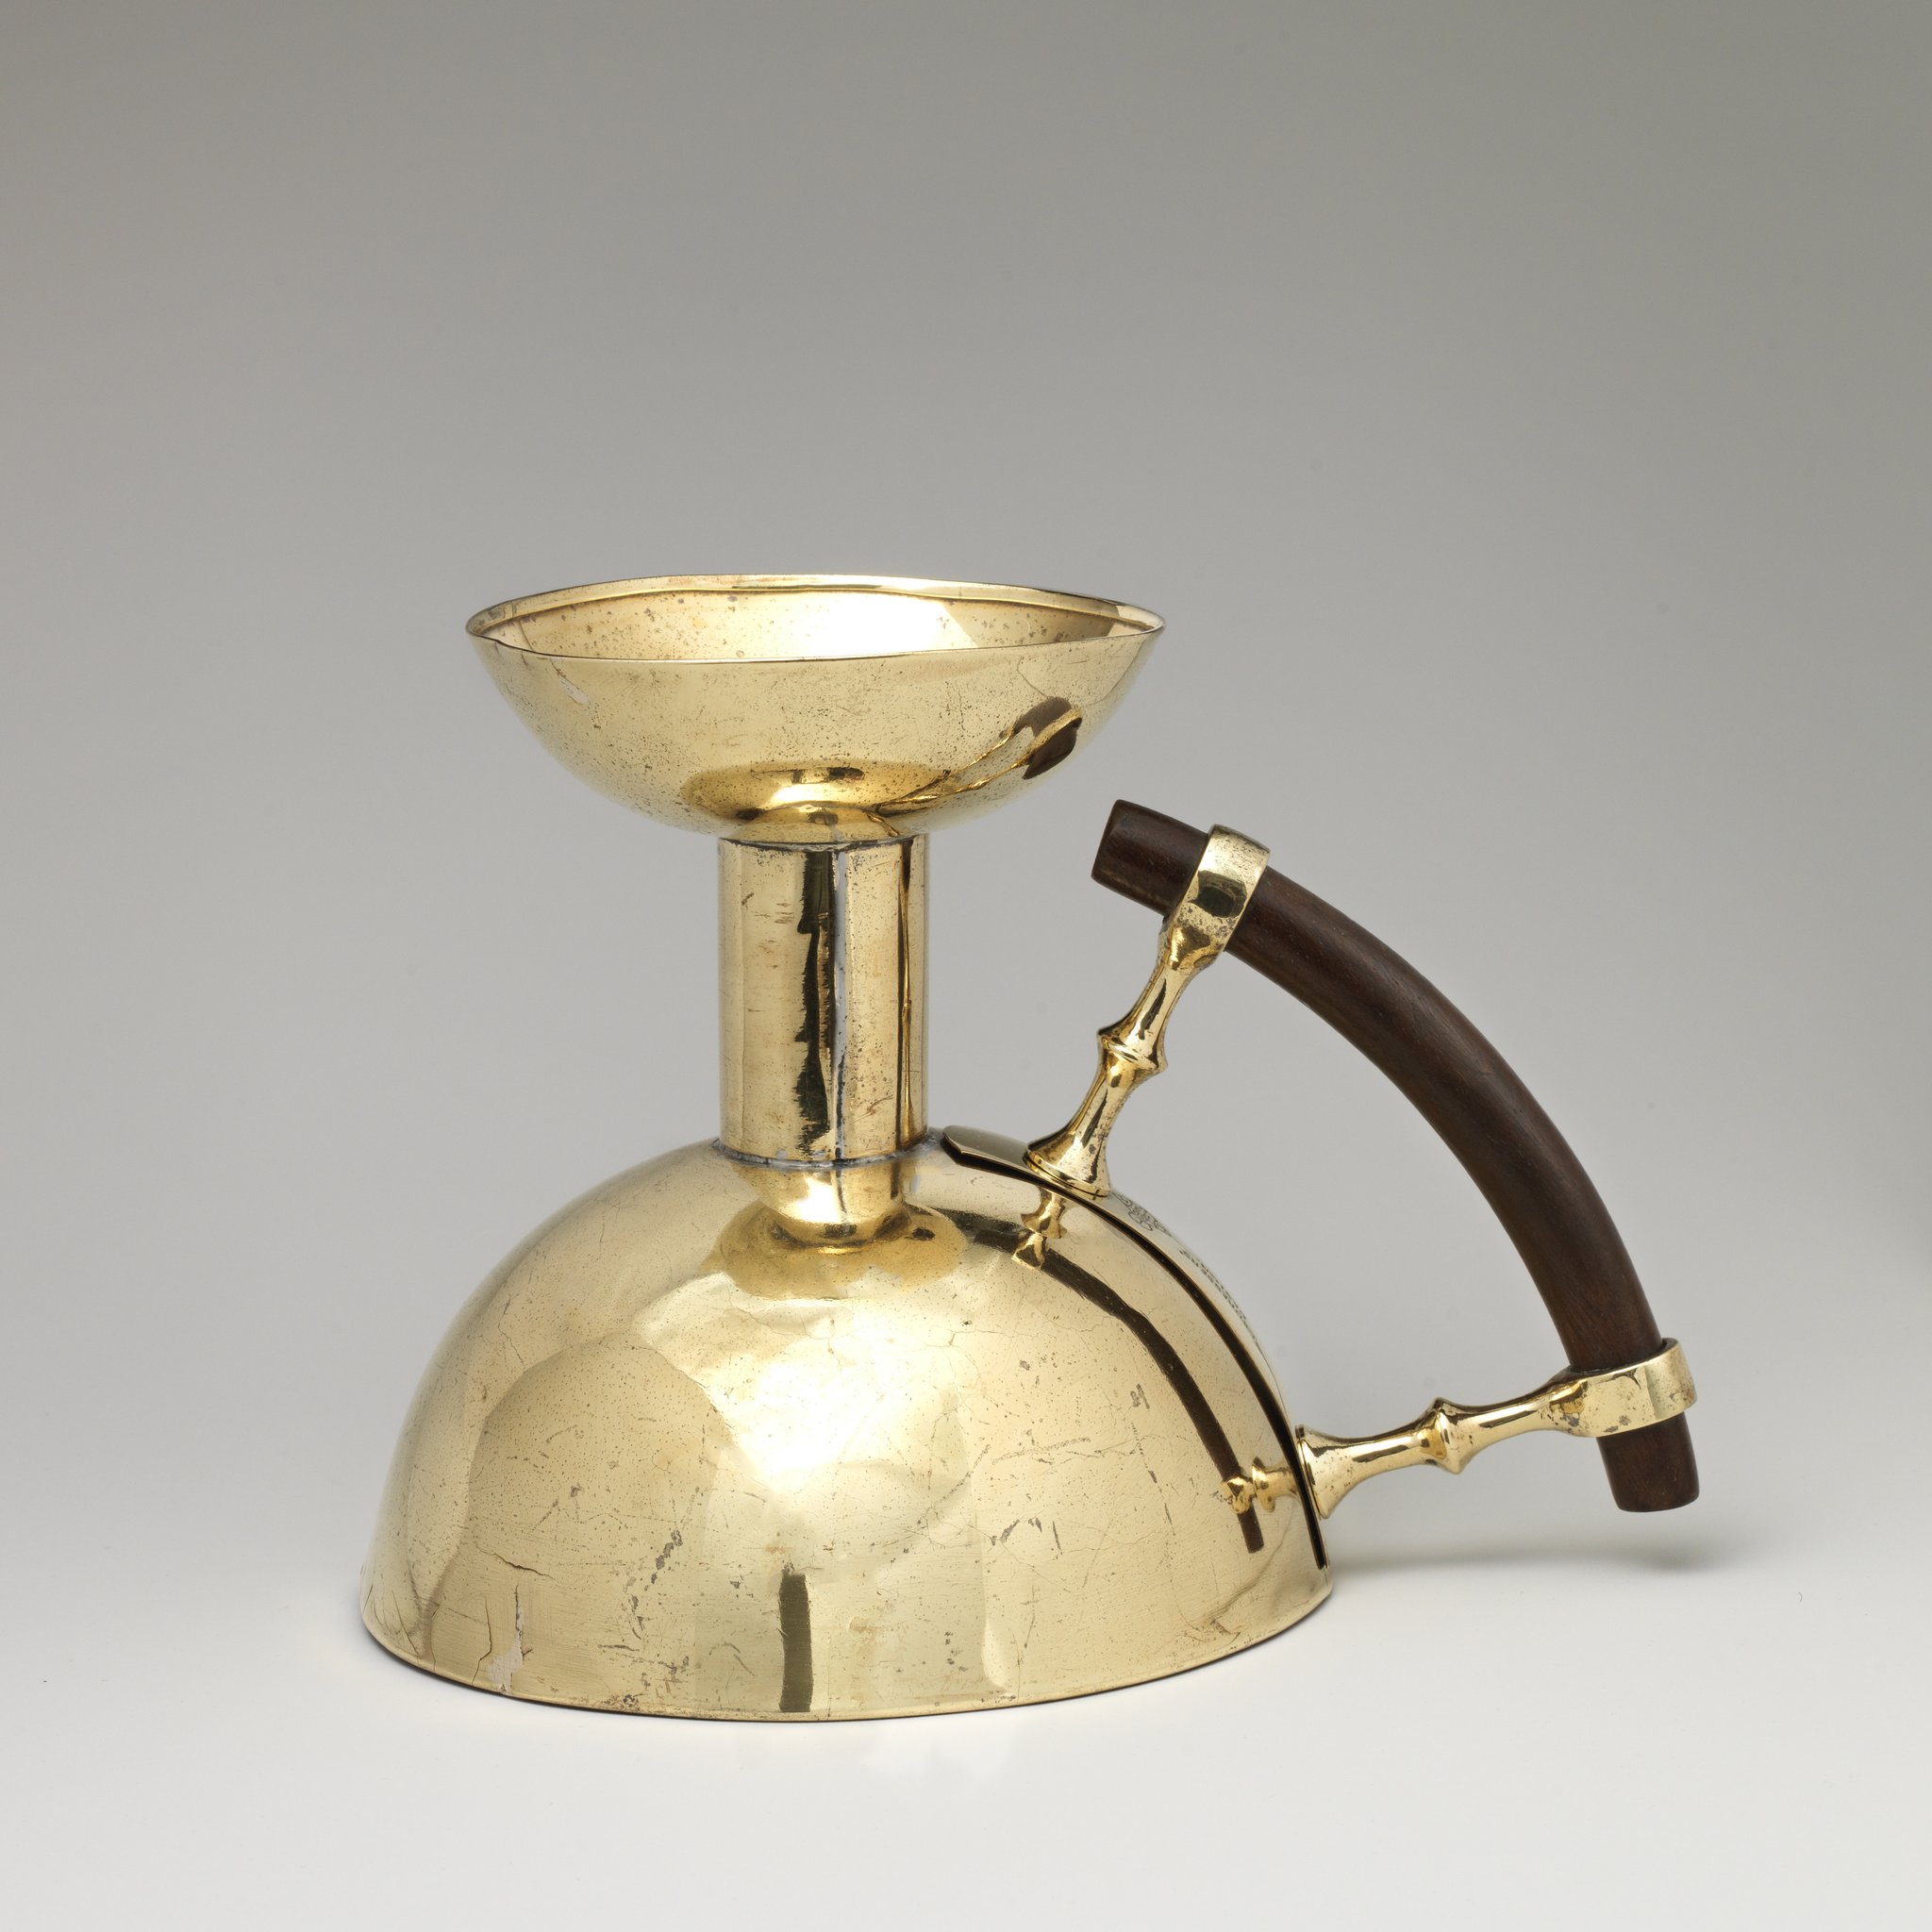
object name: candlestick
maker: christopher dresser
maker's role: designer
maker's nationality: british, scottish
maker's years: 1834-1904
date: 1883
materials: brass, wood